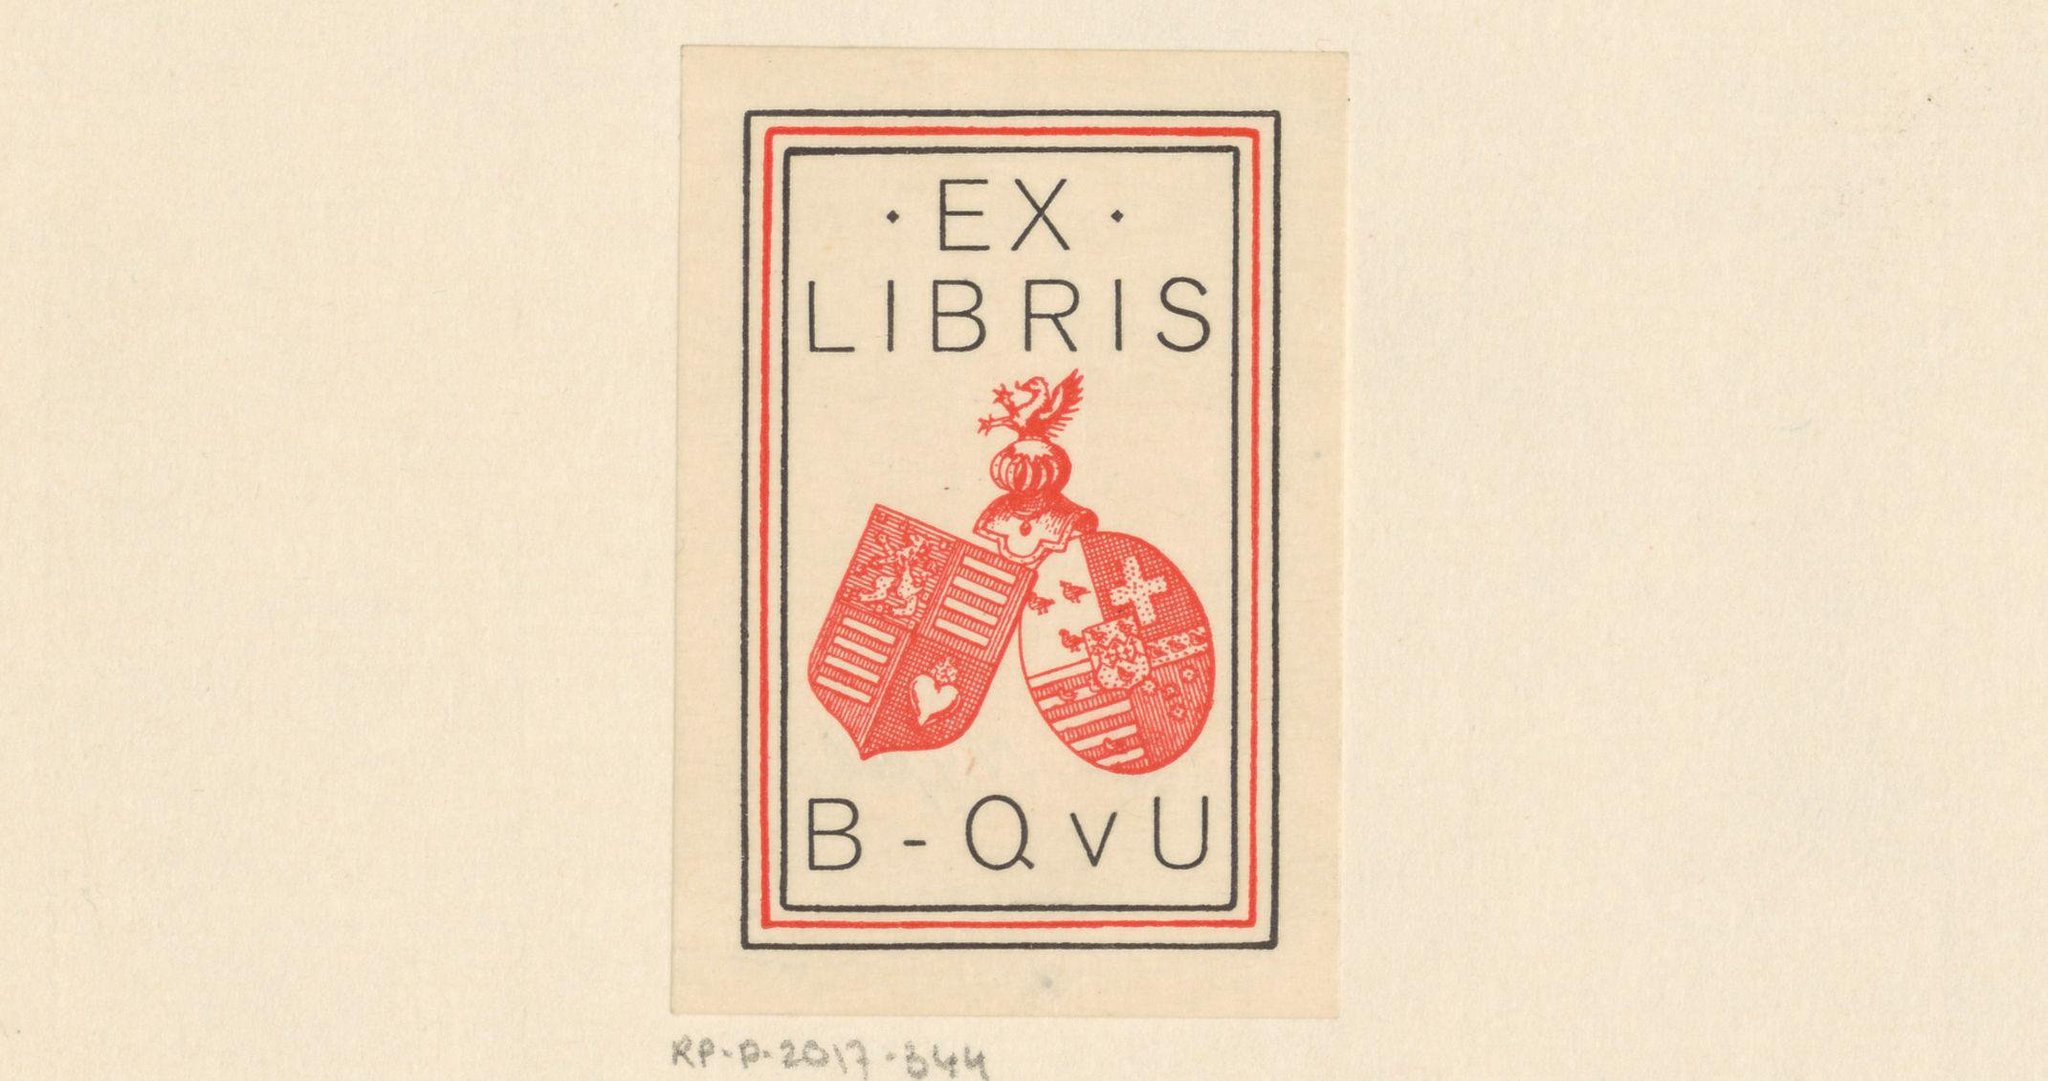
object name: bookplate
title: Ex libris van Beels-Quarles van Ufford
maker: charles nijpels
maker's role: print maker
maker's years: 1895-1952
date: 1925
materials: paper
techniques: printing block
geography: netherlands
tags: clemens haro beels, armorial bearing, heraldry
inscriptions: signature: ‘Ch. Nypels’